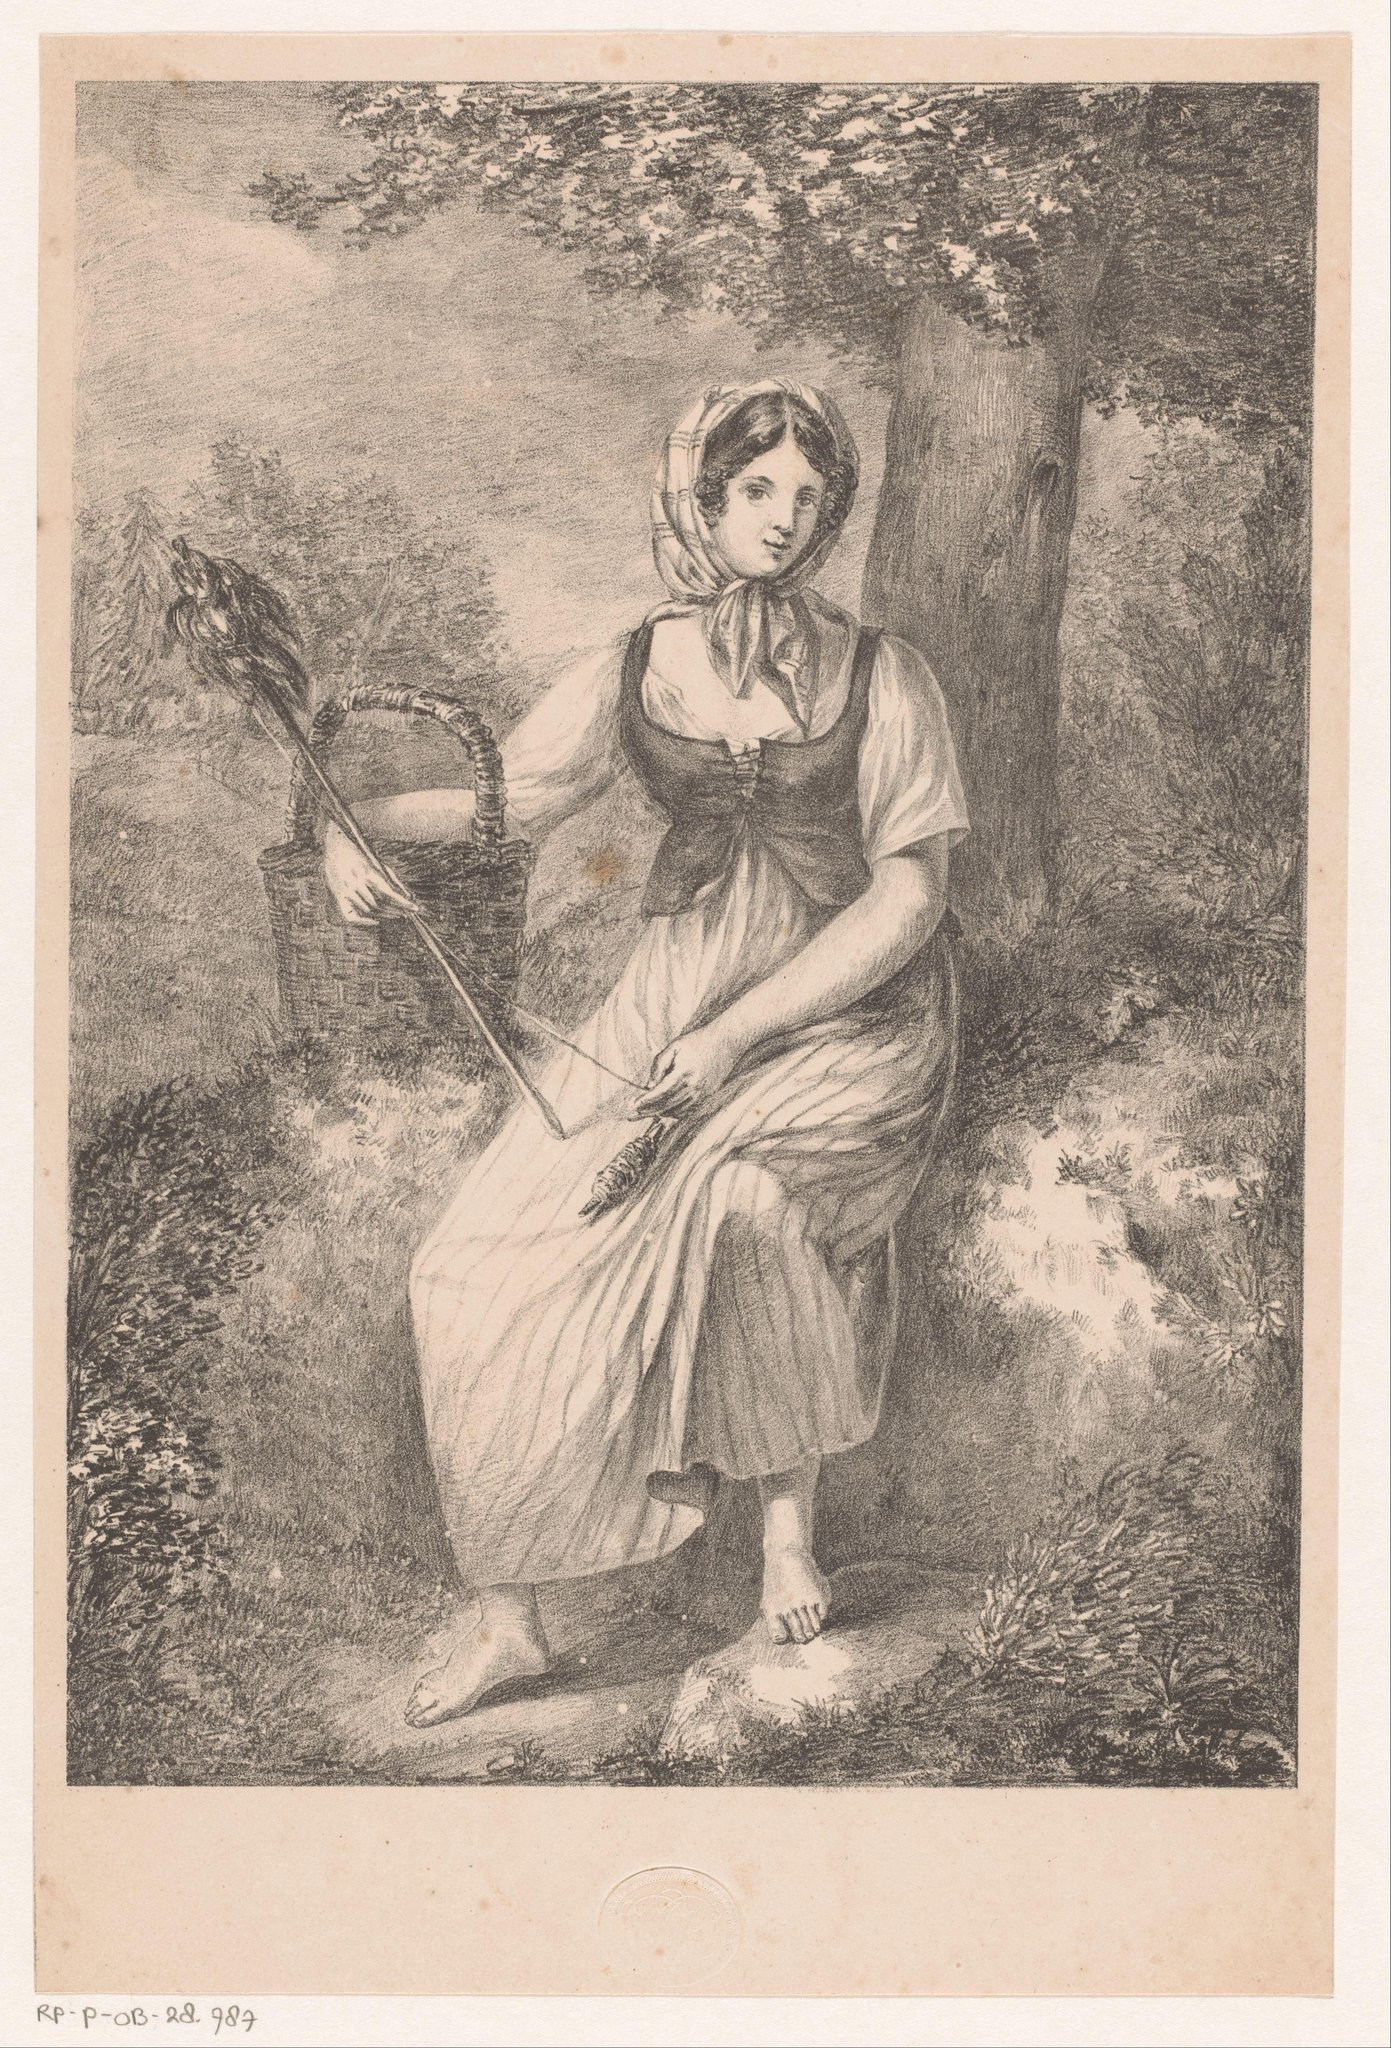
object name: print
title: Meisje met spinrokken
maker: david van der kellen (1804-1879)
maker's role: die cutter, draughtsman, print maker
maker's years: 1804-1879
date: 1814-1879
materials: paper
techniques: lithograph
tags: adolescent, young woman, maiden, industriousness, assiduity; 'assiduità', 'industria', 'zelo' (ripa), container made of plant material other than wood: basket, barefoot, spinning (manufacture of yarn)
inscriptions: collector's mark, stamp: ‘Ovaal met daarin de letters: VDK.’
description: Het meisje is blootvoets en zit onder een boom. Aan haar rechterarm hangt een mand. In haar handen heeft zij een spinrokken en een spintol. Mogelijk de personificatie van 'ijver'.